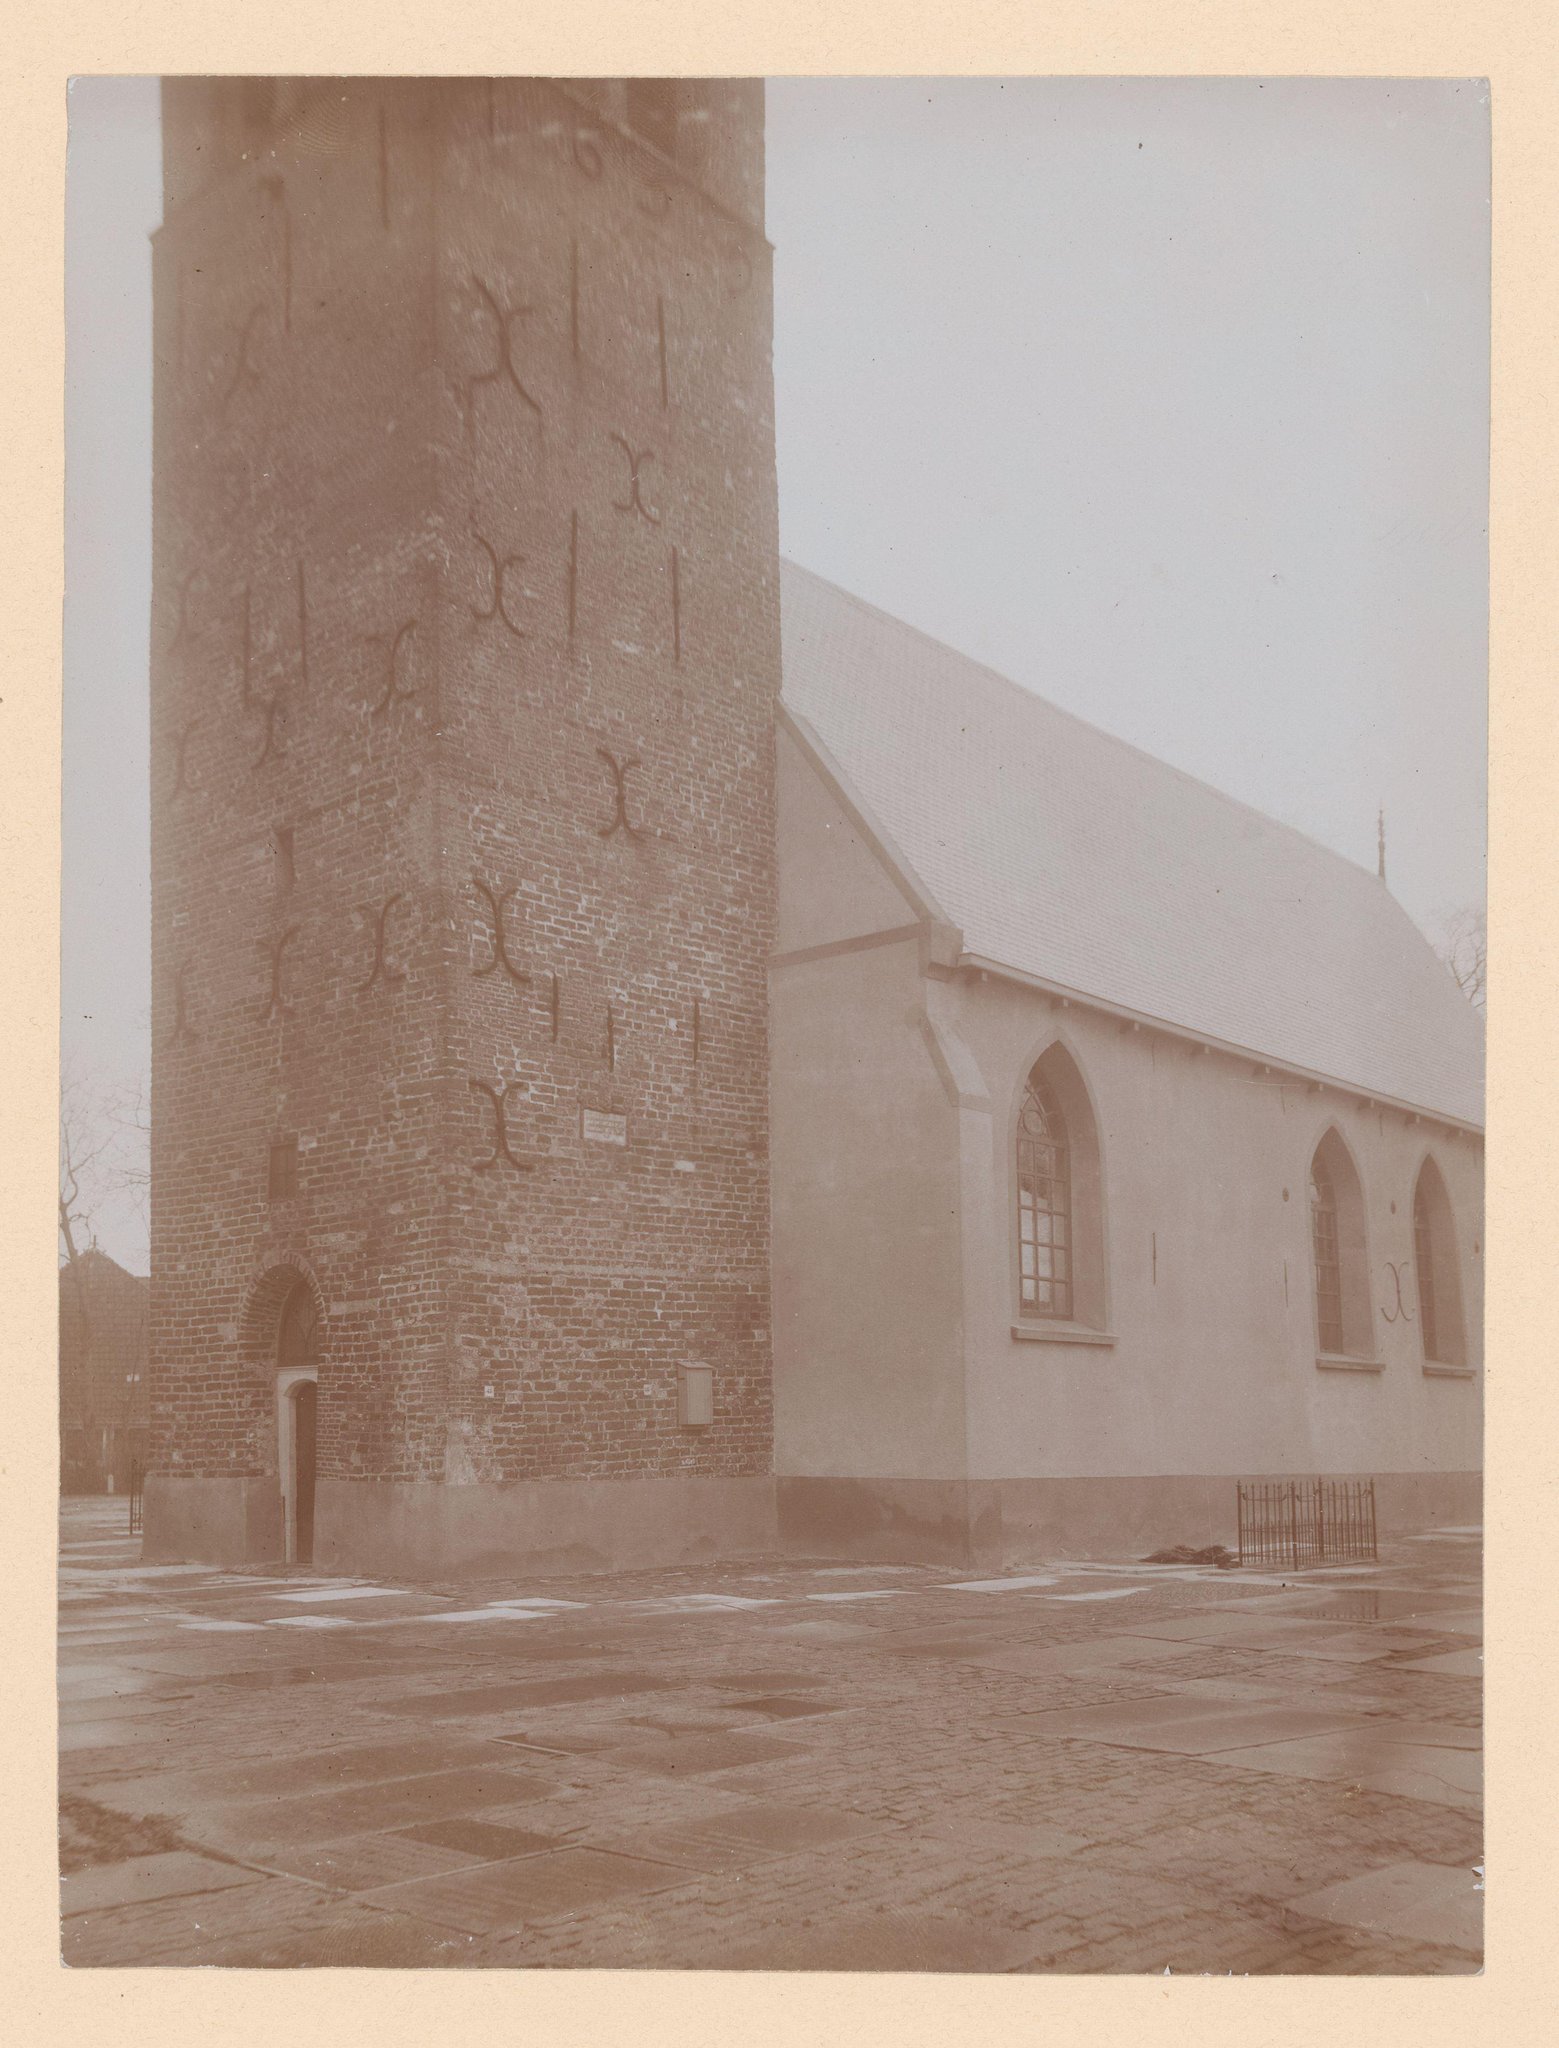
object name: photograph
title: Johannes de Doperkerk te Huizum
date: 1911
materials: cardboard, photographic support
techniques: collodion silver print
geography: huizum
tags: church (exterior)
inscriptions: annotation: ‘Detail van toren en Kerk der Ned. Herv Gem te Huizum (Fr) Jan 1911 / Leeuwarderadeel’